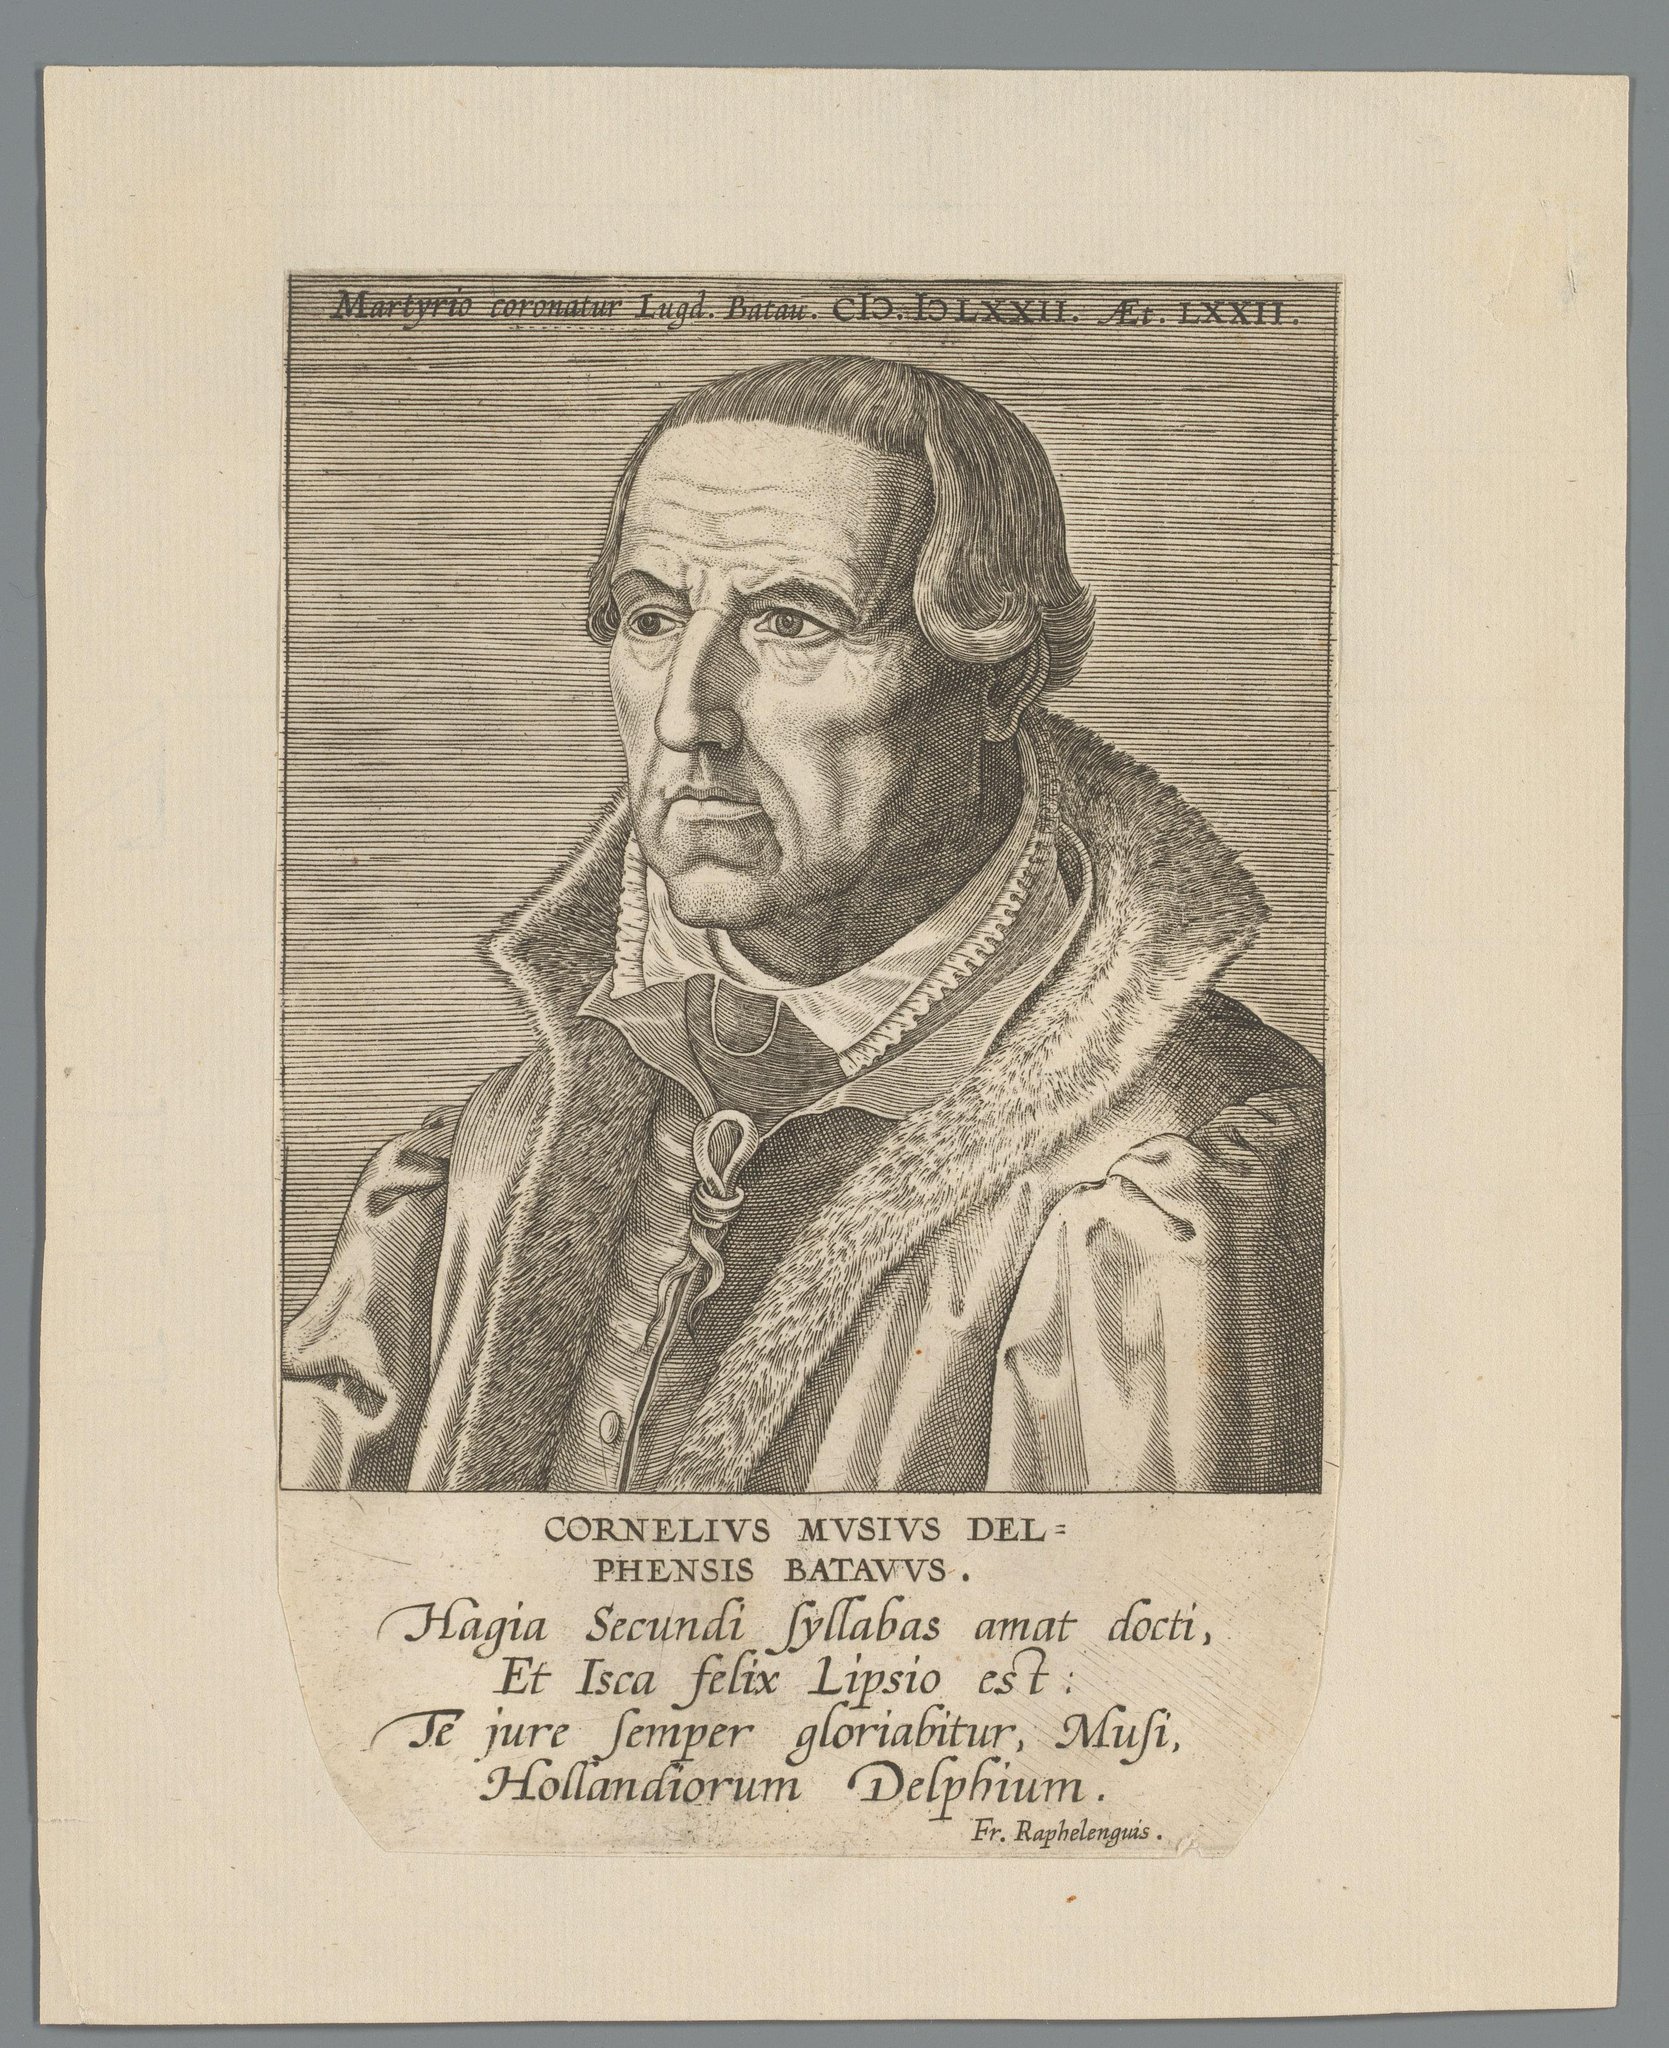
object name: print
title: Illustrium Galliae Belgicae scriptorum icones et elogi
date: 1604-1608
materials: paper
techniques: engraving, snipping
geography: haarlem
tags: delft, leiden, priest, cornelis musius, historical persons, portrait of a writer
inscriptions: inscription: ‘Levensbeschr. van eenige (...) Hoofdst. VII: 281, 282.’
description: Prent waarschijnlijk uit: Le-Mire, Aubertus. Illustrium Galliae Belgicae Scriptorum icones et elogia. Antwerpen: Theodoor Galle, 1609.